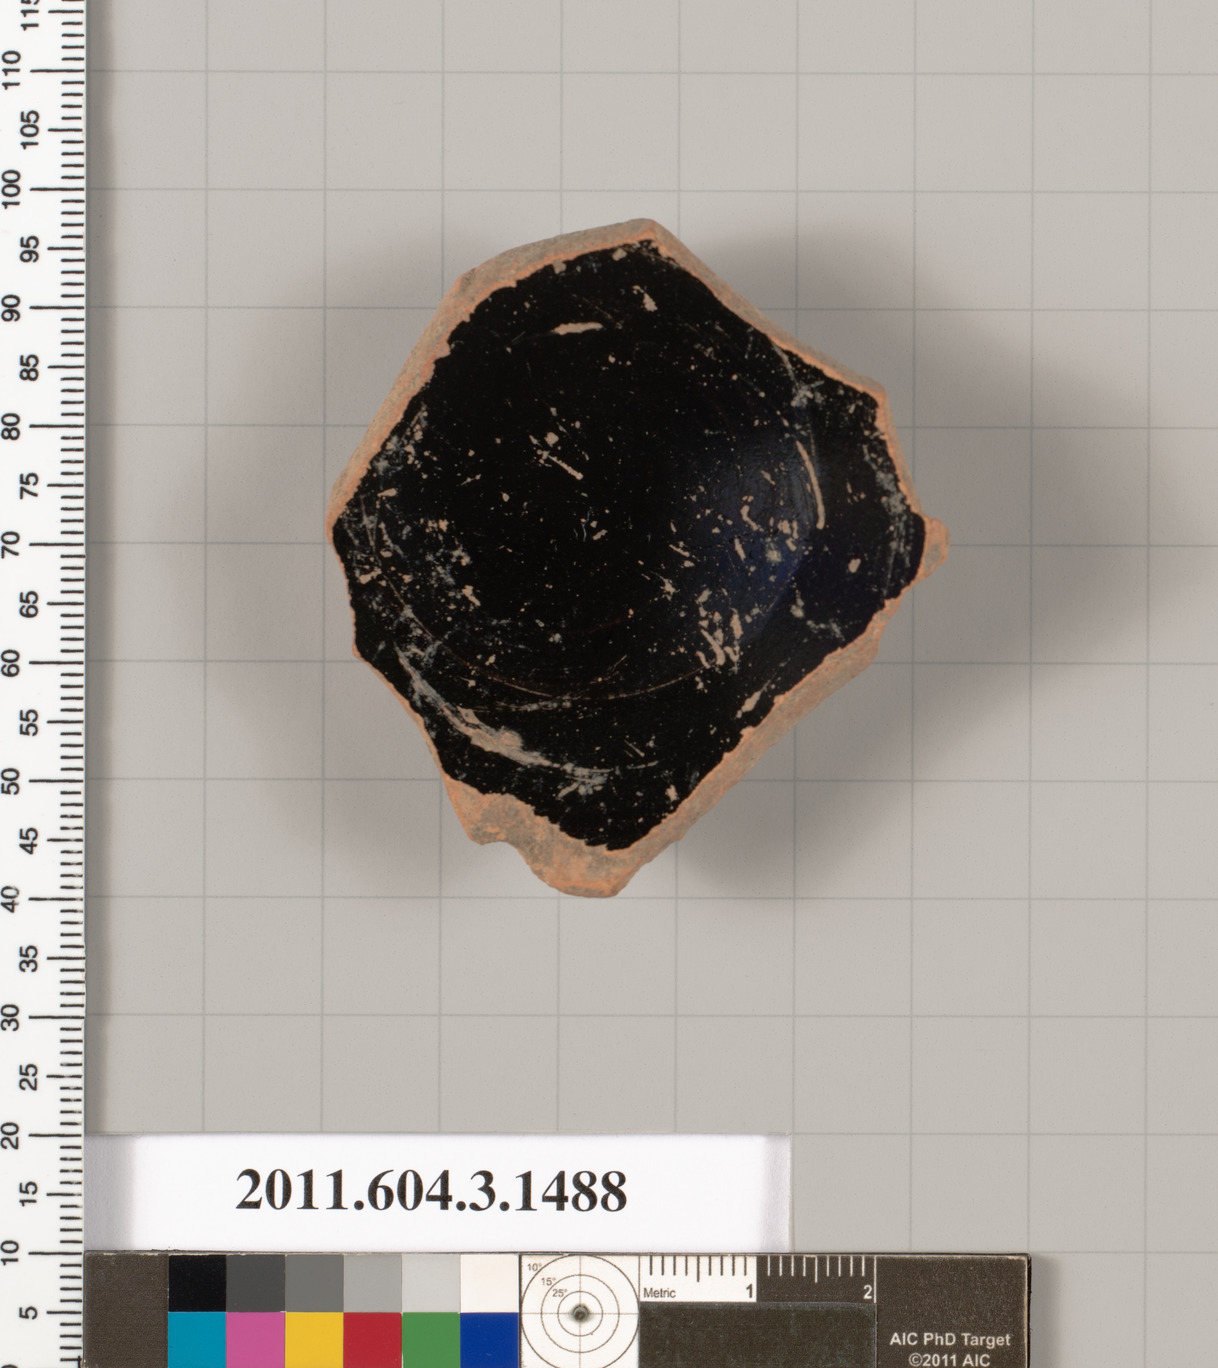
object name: skyphos fragment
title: Terracotta fragment of a skyphos (deep drinking cup)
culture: greek, attic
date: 600-501 BCE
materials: terracotta